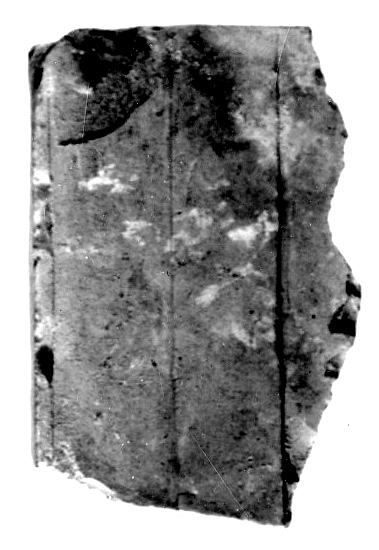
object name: relief fragment, tomb of meketre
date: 1981-1975 BCE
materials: limestone, paint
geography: egypt